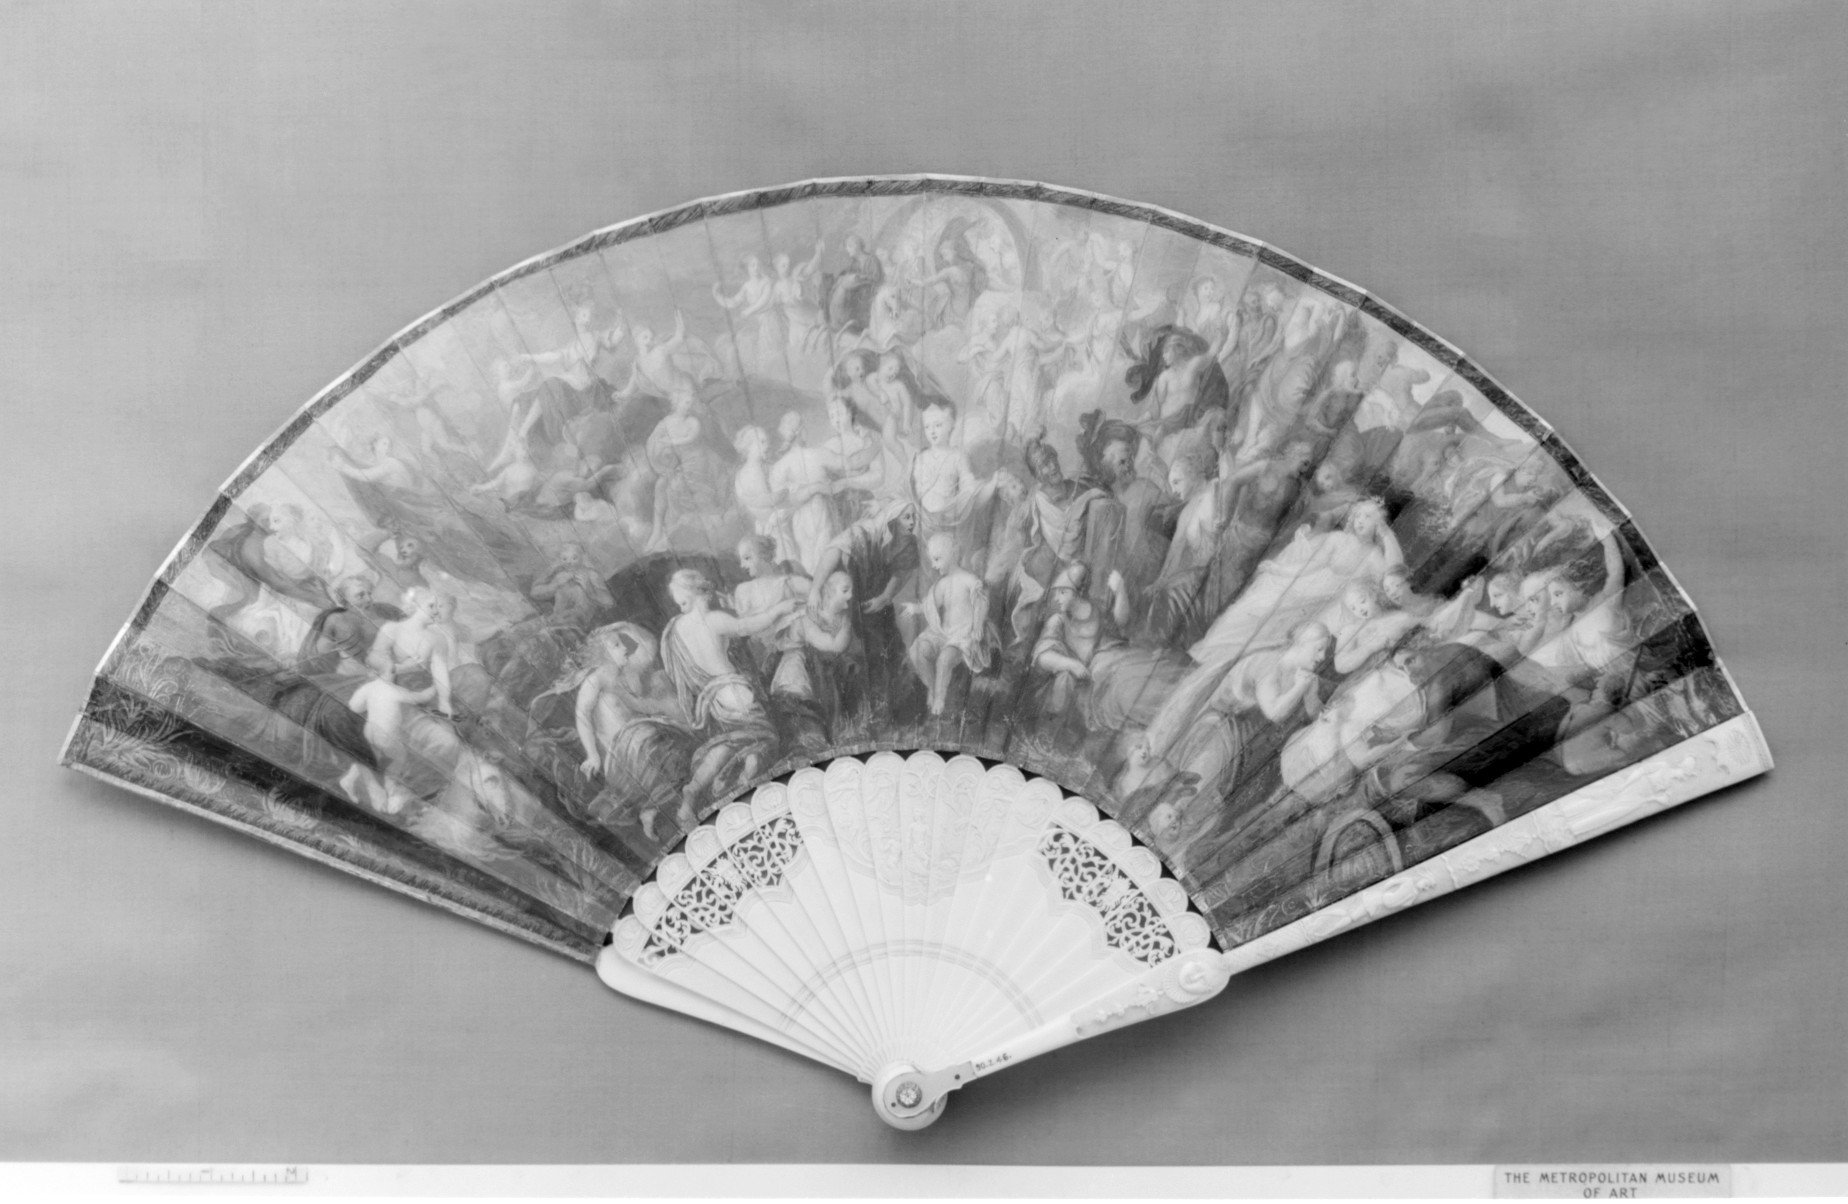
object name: fan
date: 1701-1733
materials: ivory, paper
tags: men,women